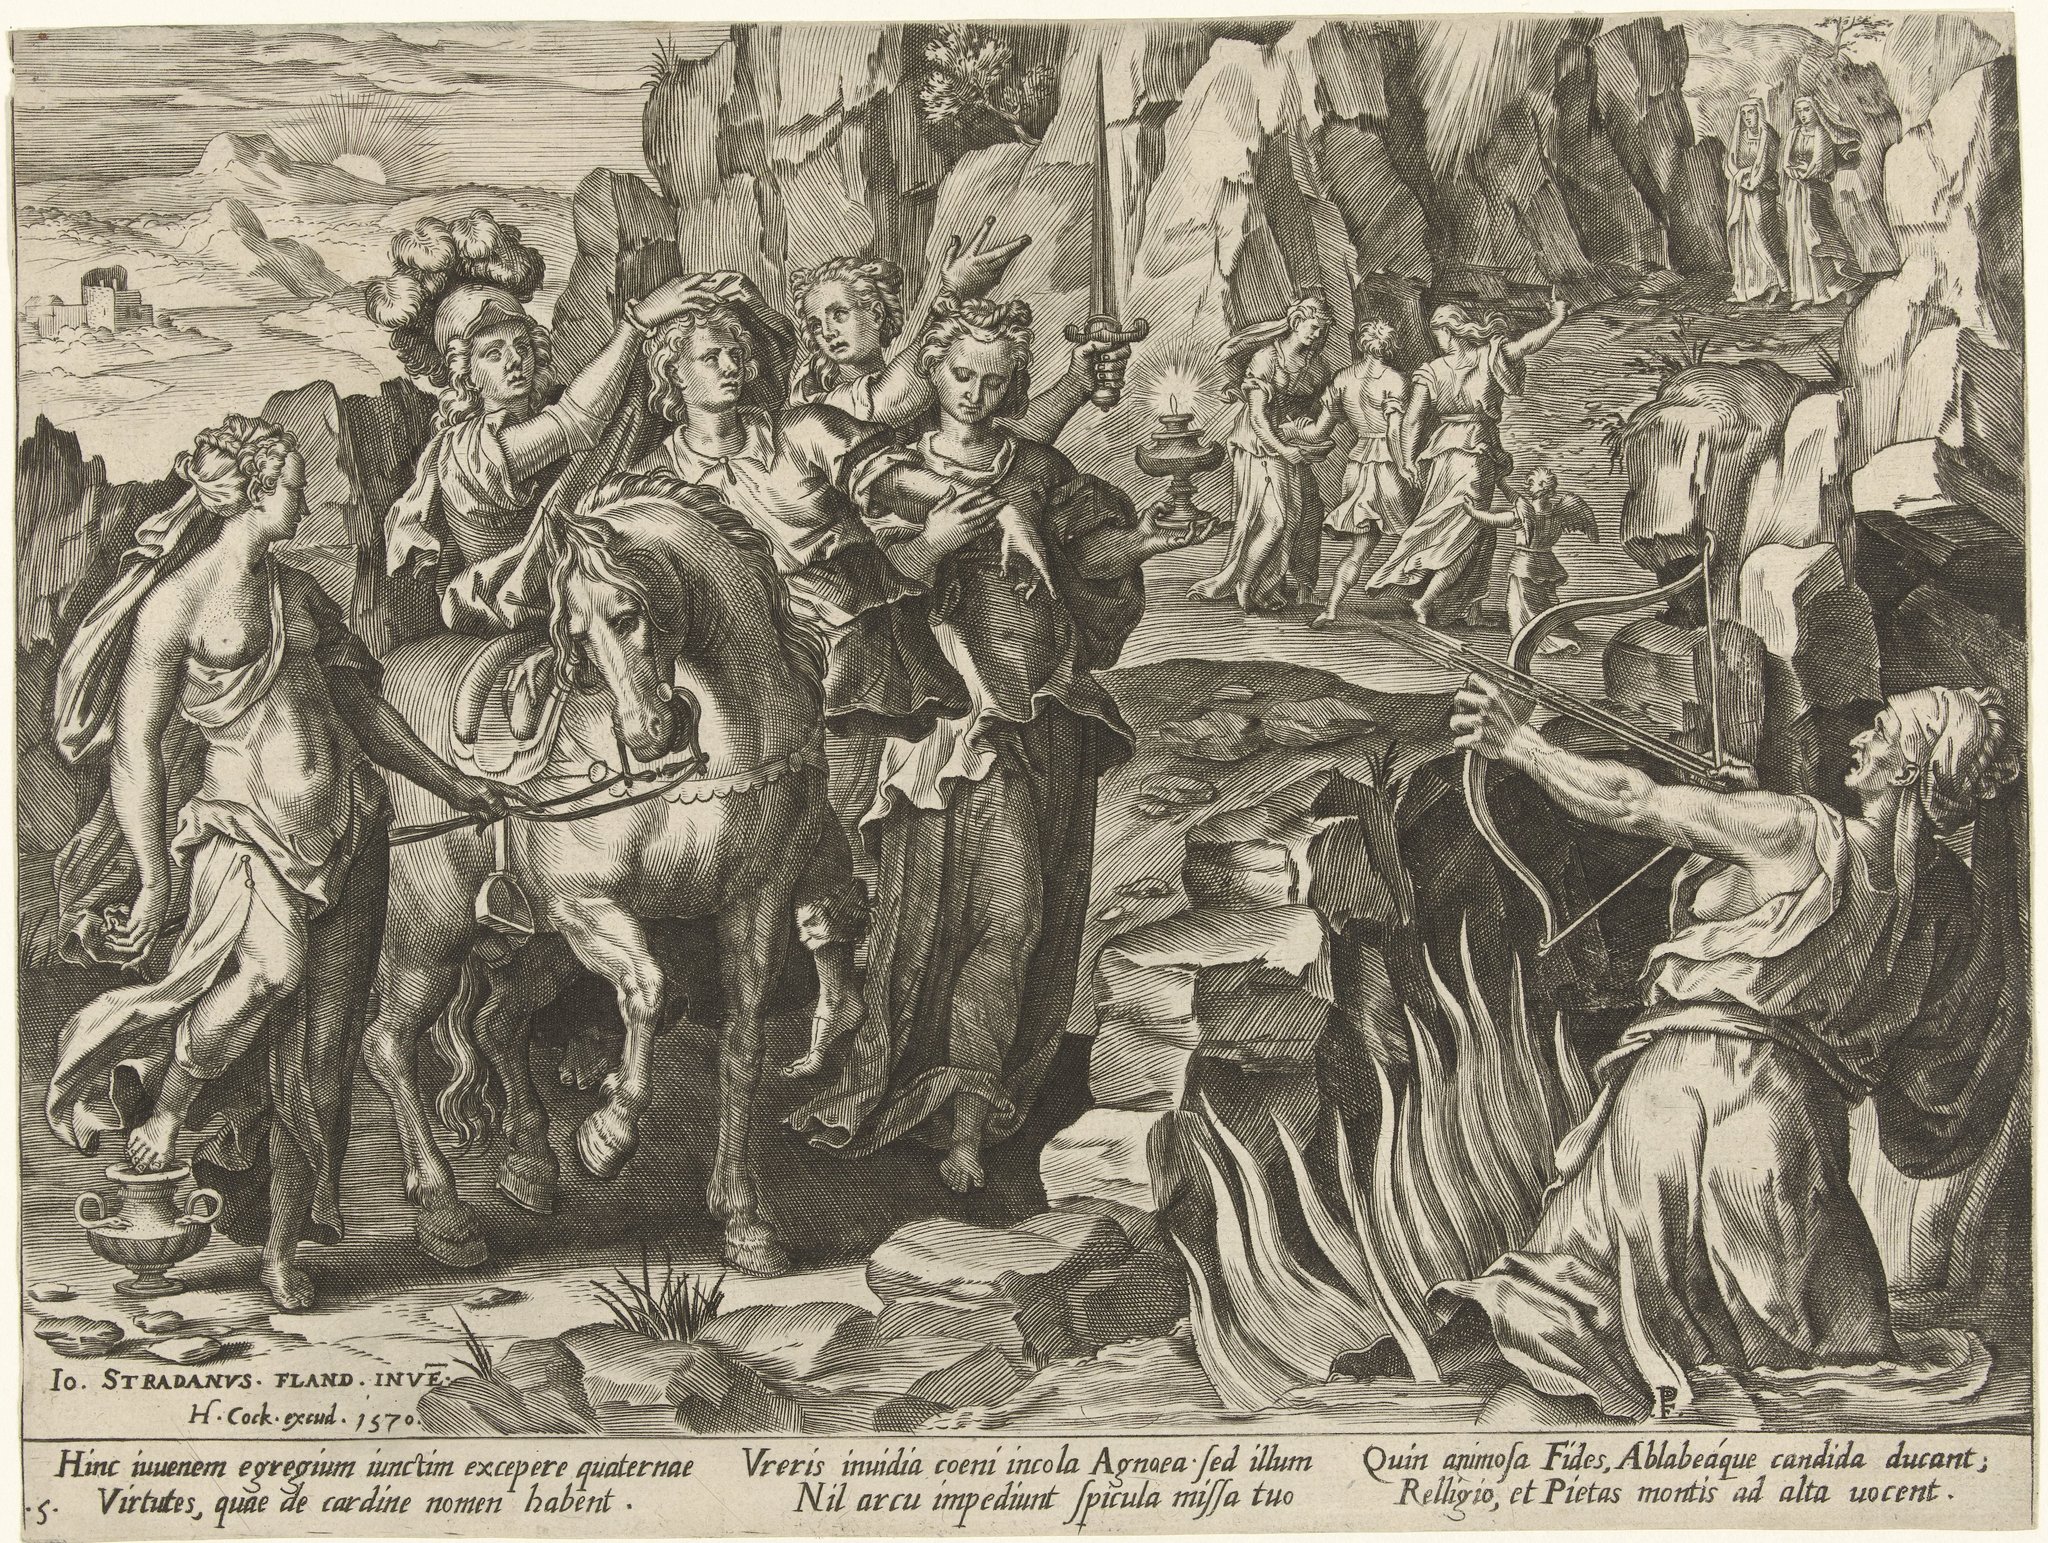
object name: print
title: Kiezen van de deugd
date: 1570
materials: paper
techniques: engraving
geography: antwerp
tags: faith, 'fides'; 'fede', 'fede catholica', 'fede christiana', 'fede christiana catholica' (ripa) ~ one of the three theological virtues, envy; 'invidia' (ripa) ~ personification of one of the seven deadly sins, innocence; 'innocenza', 'innocenza o purità' (ripa), youth, adolescence, 'iuventus'; 'adolescenza', 'gioventù' (ripa), distinction between good and bad; 'distintione del bene & del male' (ripa)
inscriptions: collector's mark: Lugt 2228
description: De personificaties van Geloof en Onschuld beschermen een jongeman tegen de pijlen die de Afgunst op hem richt. Rechts op de achtergrond maakt dezelfde jongen kennis met het Christelijke Geloof. Onder de voorstelling staat een tekst in het Latijn, links in de marge genummerd: 5. De prent maakt deel uit van een serie allegorische prenten op het leven van de mens.